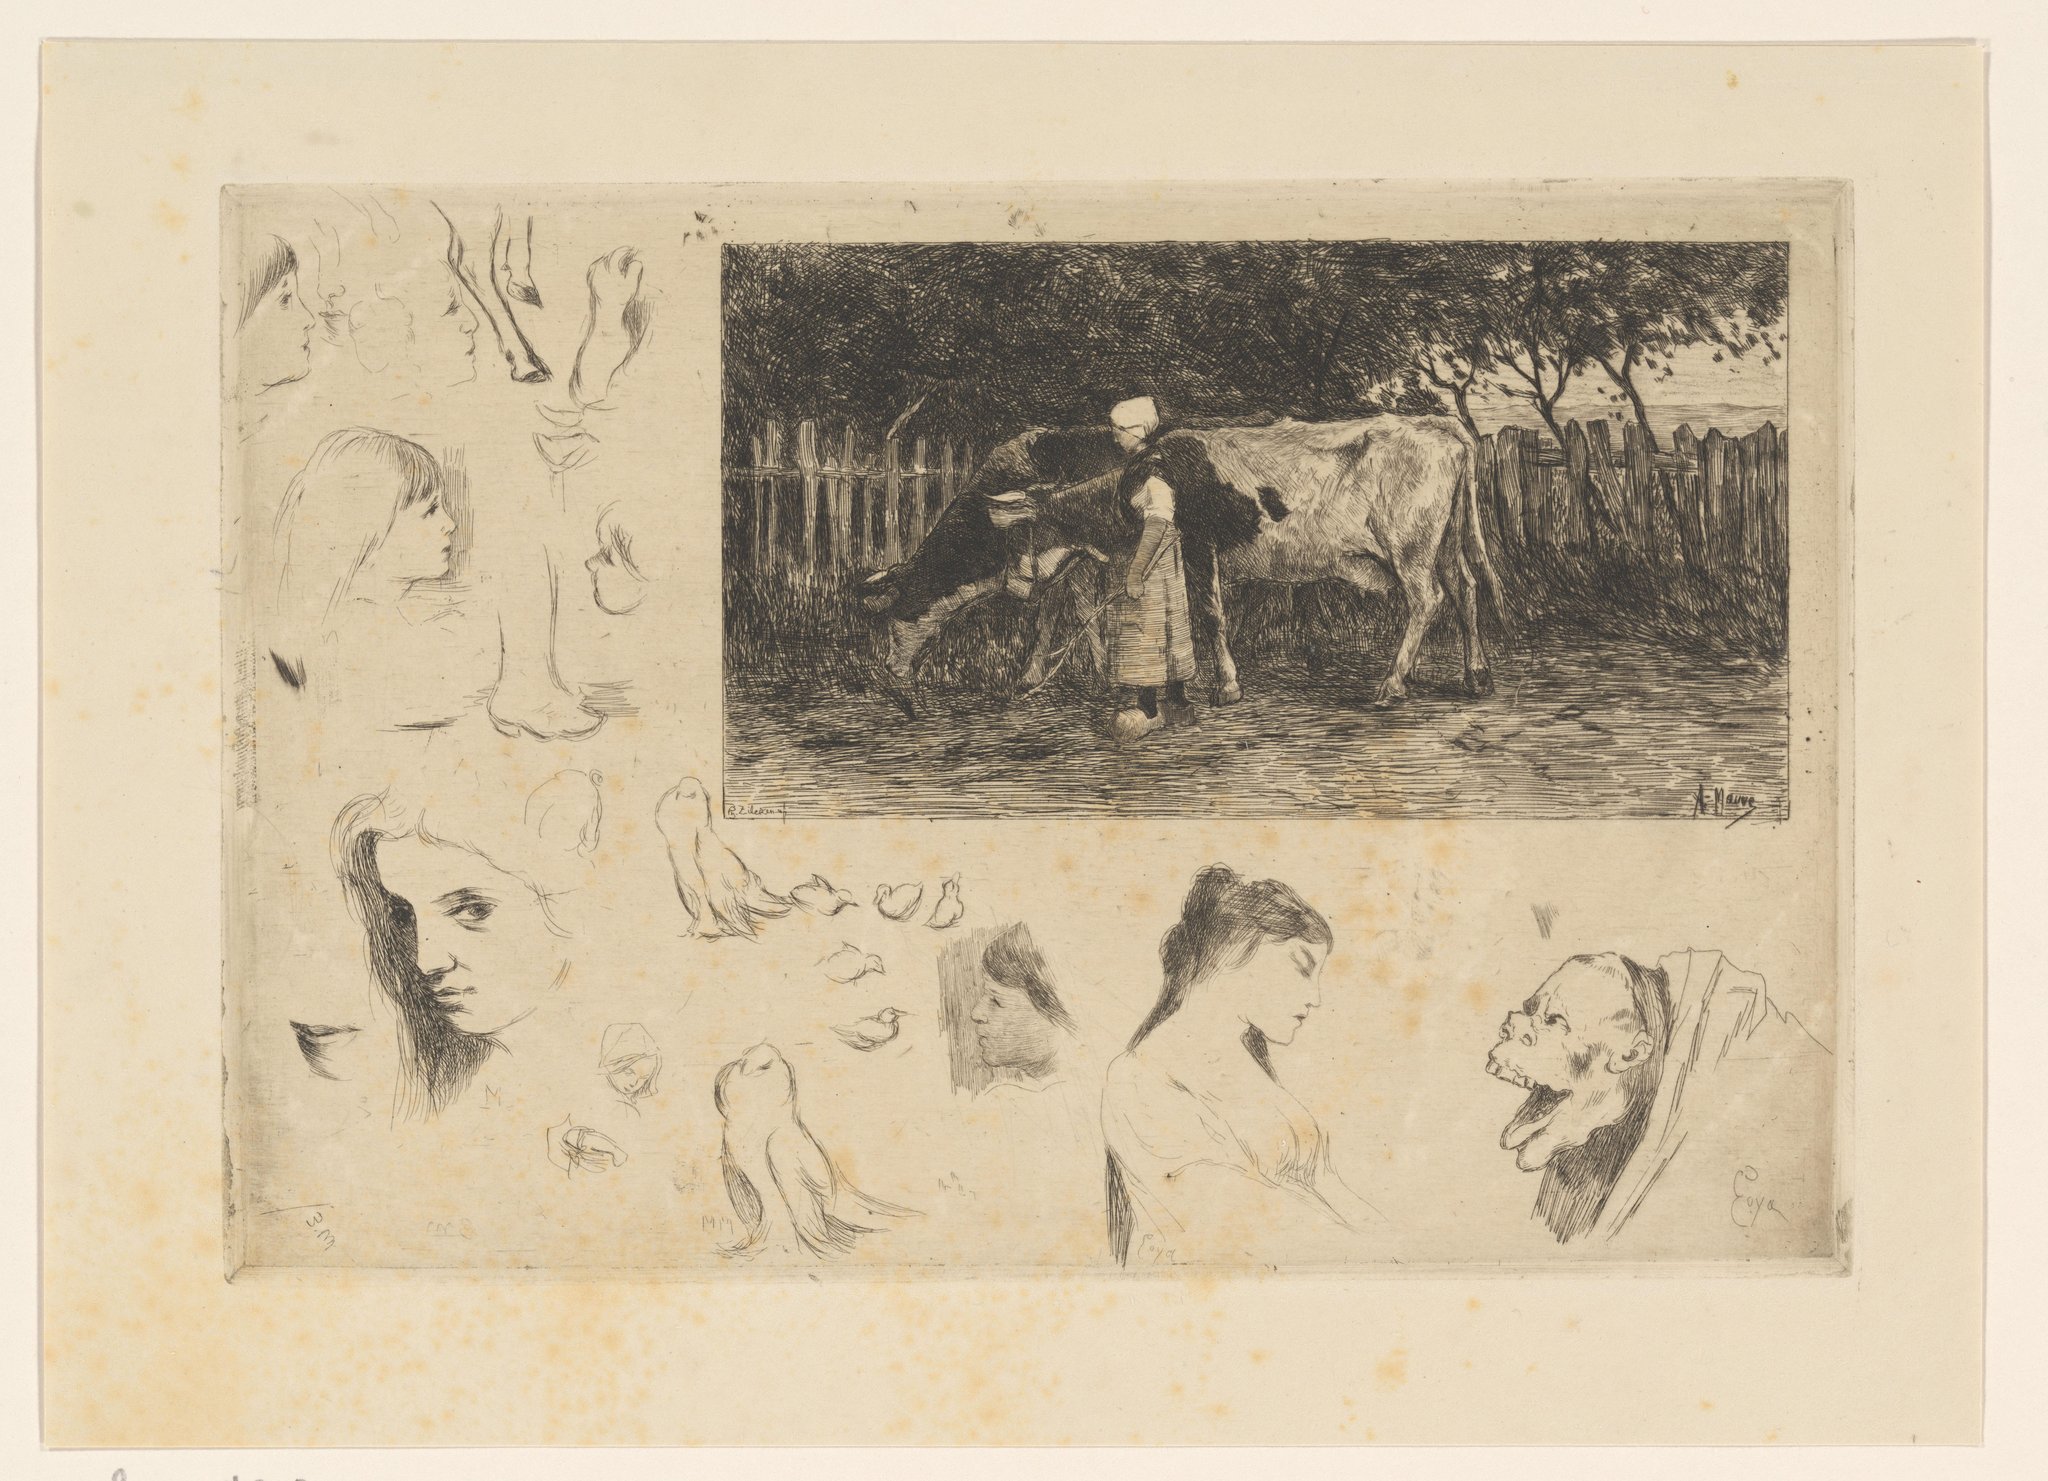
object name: print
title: Jeune fille avec des vaches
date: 1888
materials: paper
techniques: drypoint, etching, intaglio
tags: cow, birds, monk(s), friar(s), girl (child between toddler and youth)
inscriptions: collector's mark: Lugt 2233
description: Prent is ook gebruikt in: Memorial catalogue of the French and Dutch. Edinburgh: David Douglas, 1888.